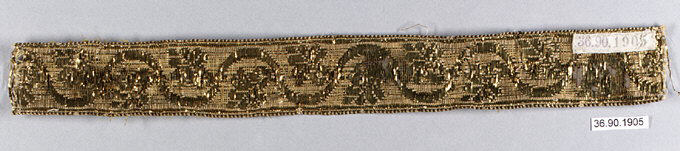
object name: galloon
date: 1767-1833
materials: silk